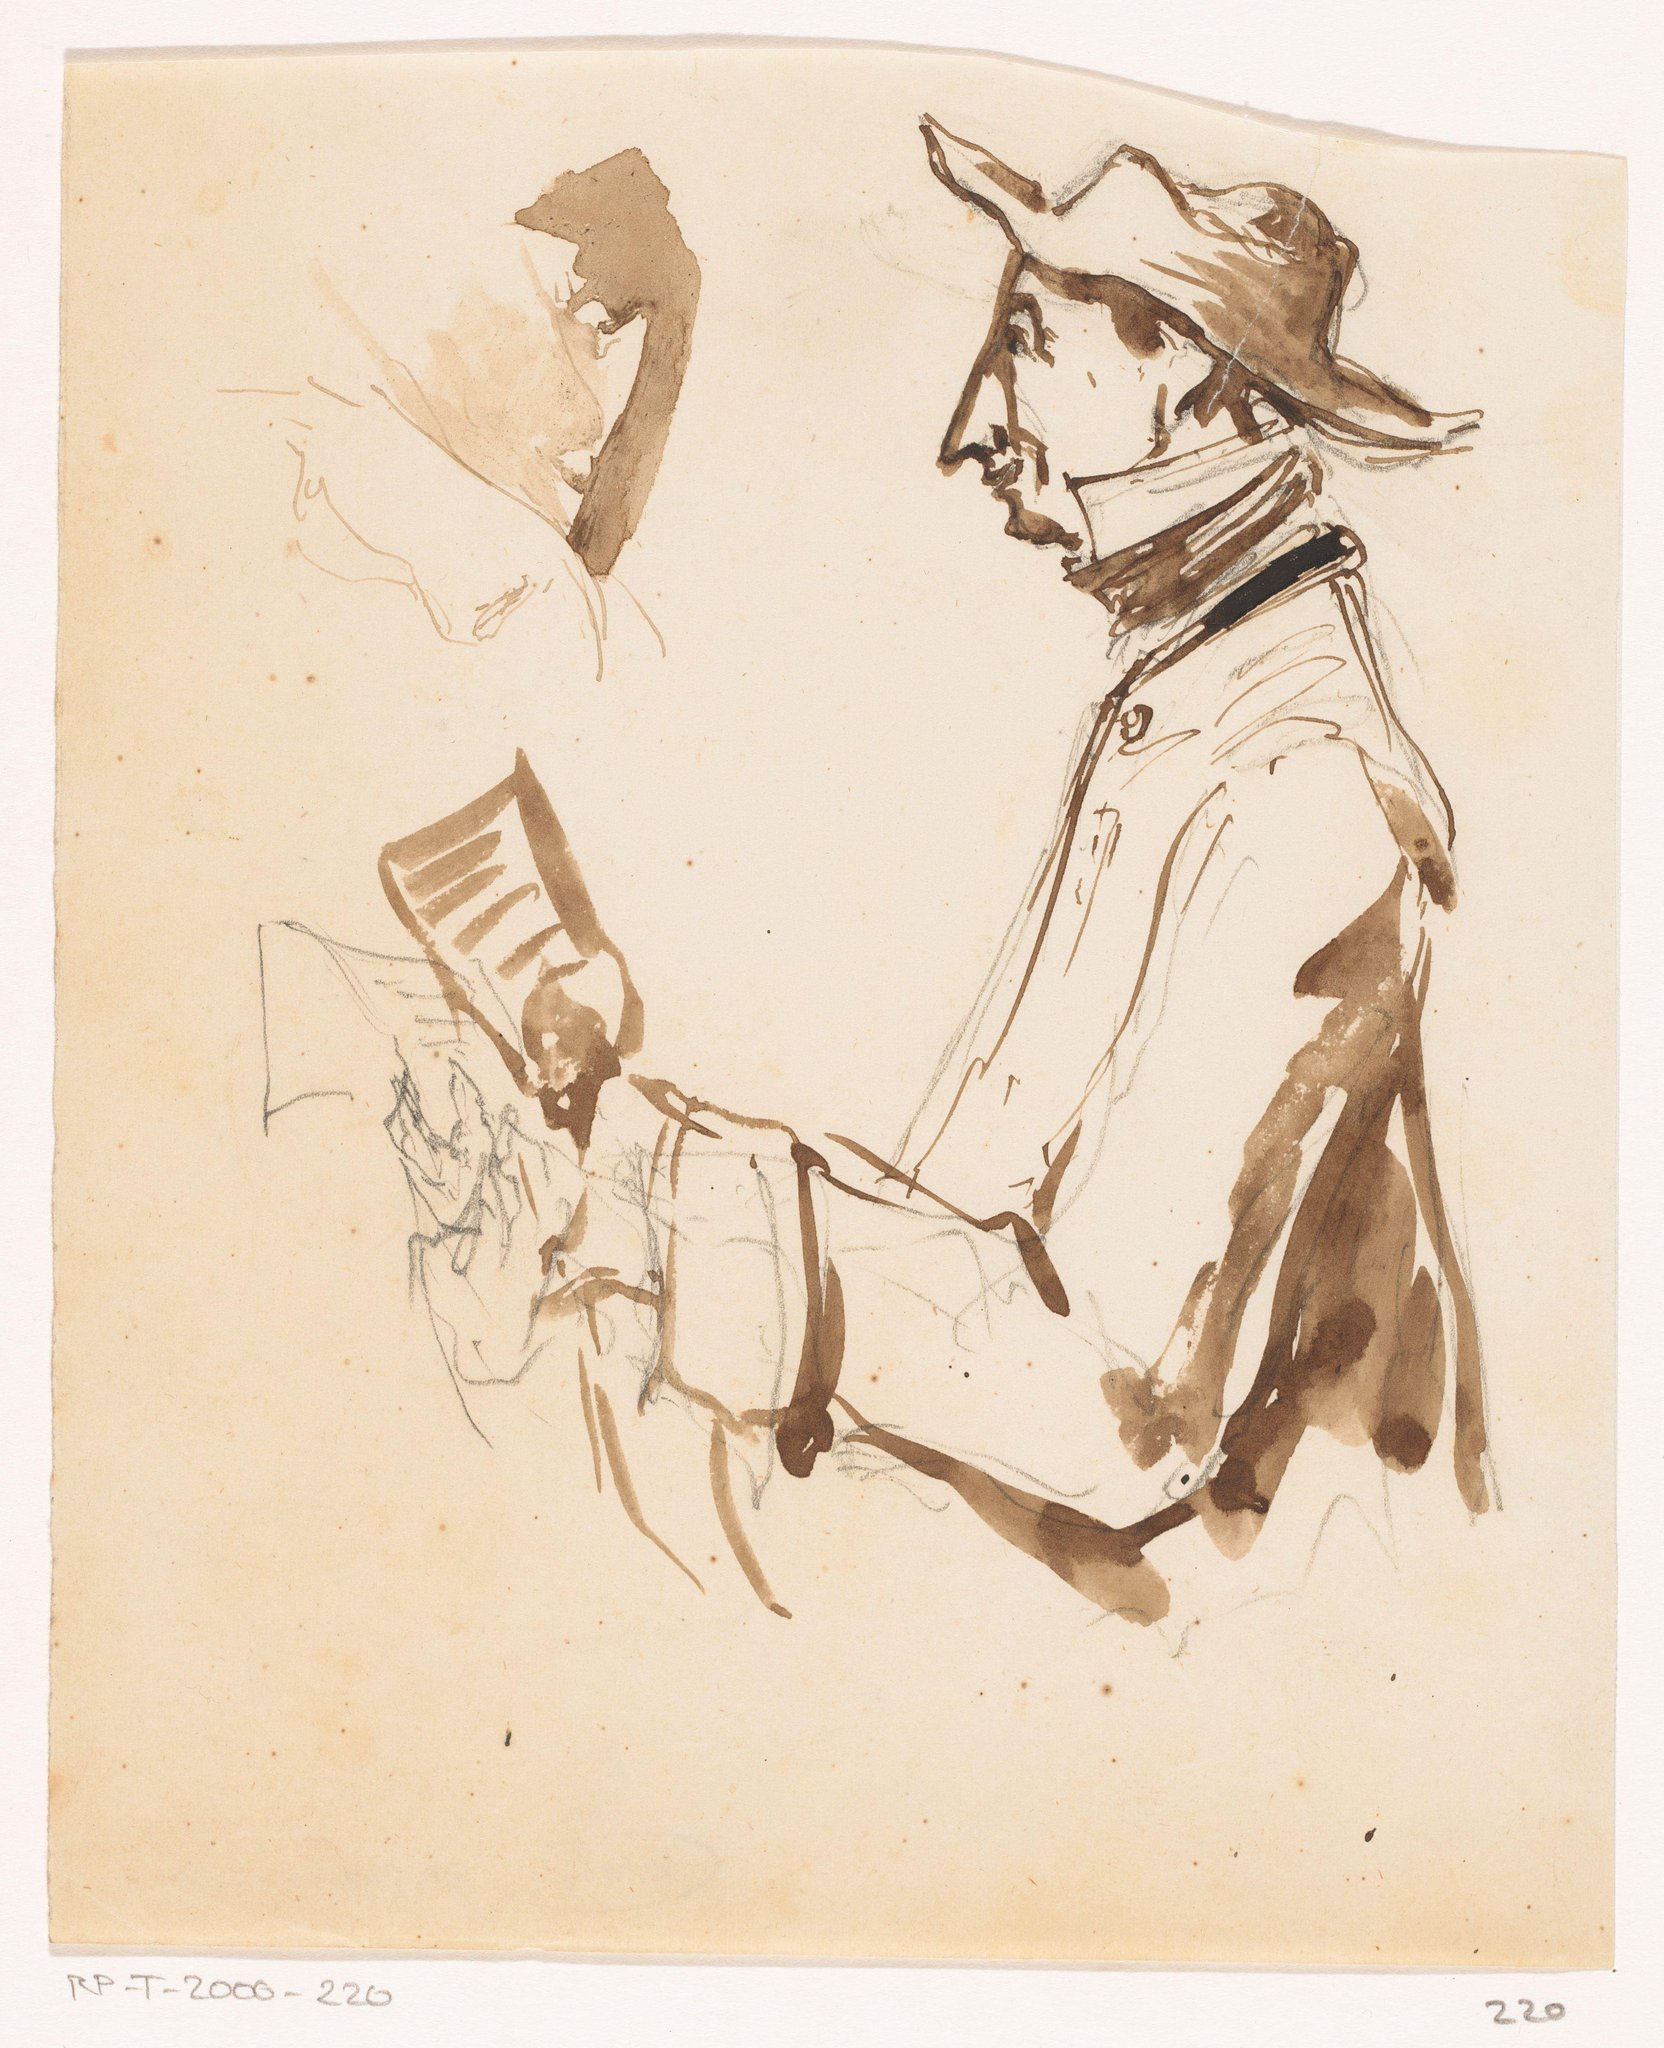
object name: drawing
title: Mansportret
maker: johannes tavenraat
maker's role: draughtsman, painter, print maker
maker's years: 1809-1881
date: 1840-1880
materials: ink, paper, pencil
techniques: brush, pen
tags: anonymous historical person portrayed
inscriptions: collector's mark: Lugt 2228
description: Portret van een man met hoed en opvallende neus, en profil naar links, een krant of tekstblad in de handen.